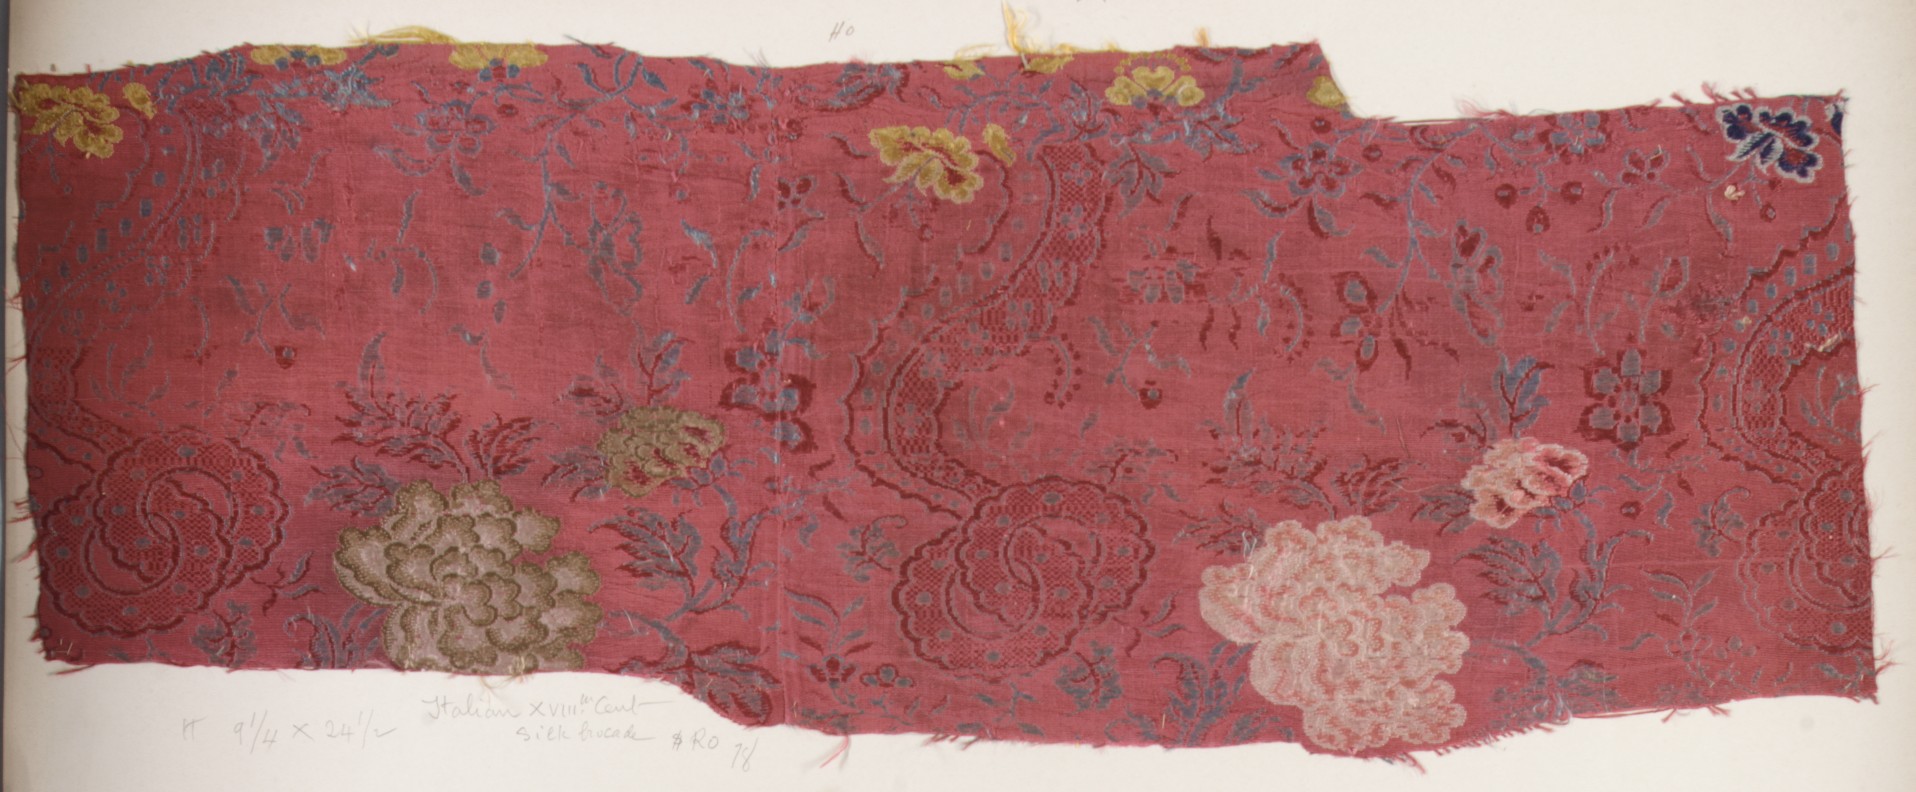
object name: fragment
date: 1701-1800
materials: silk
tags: flowers